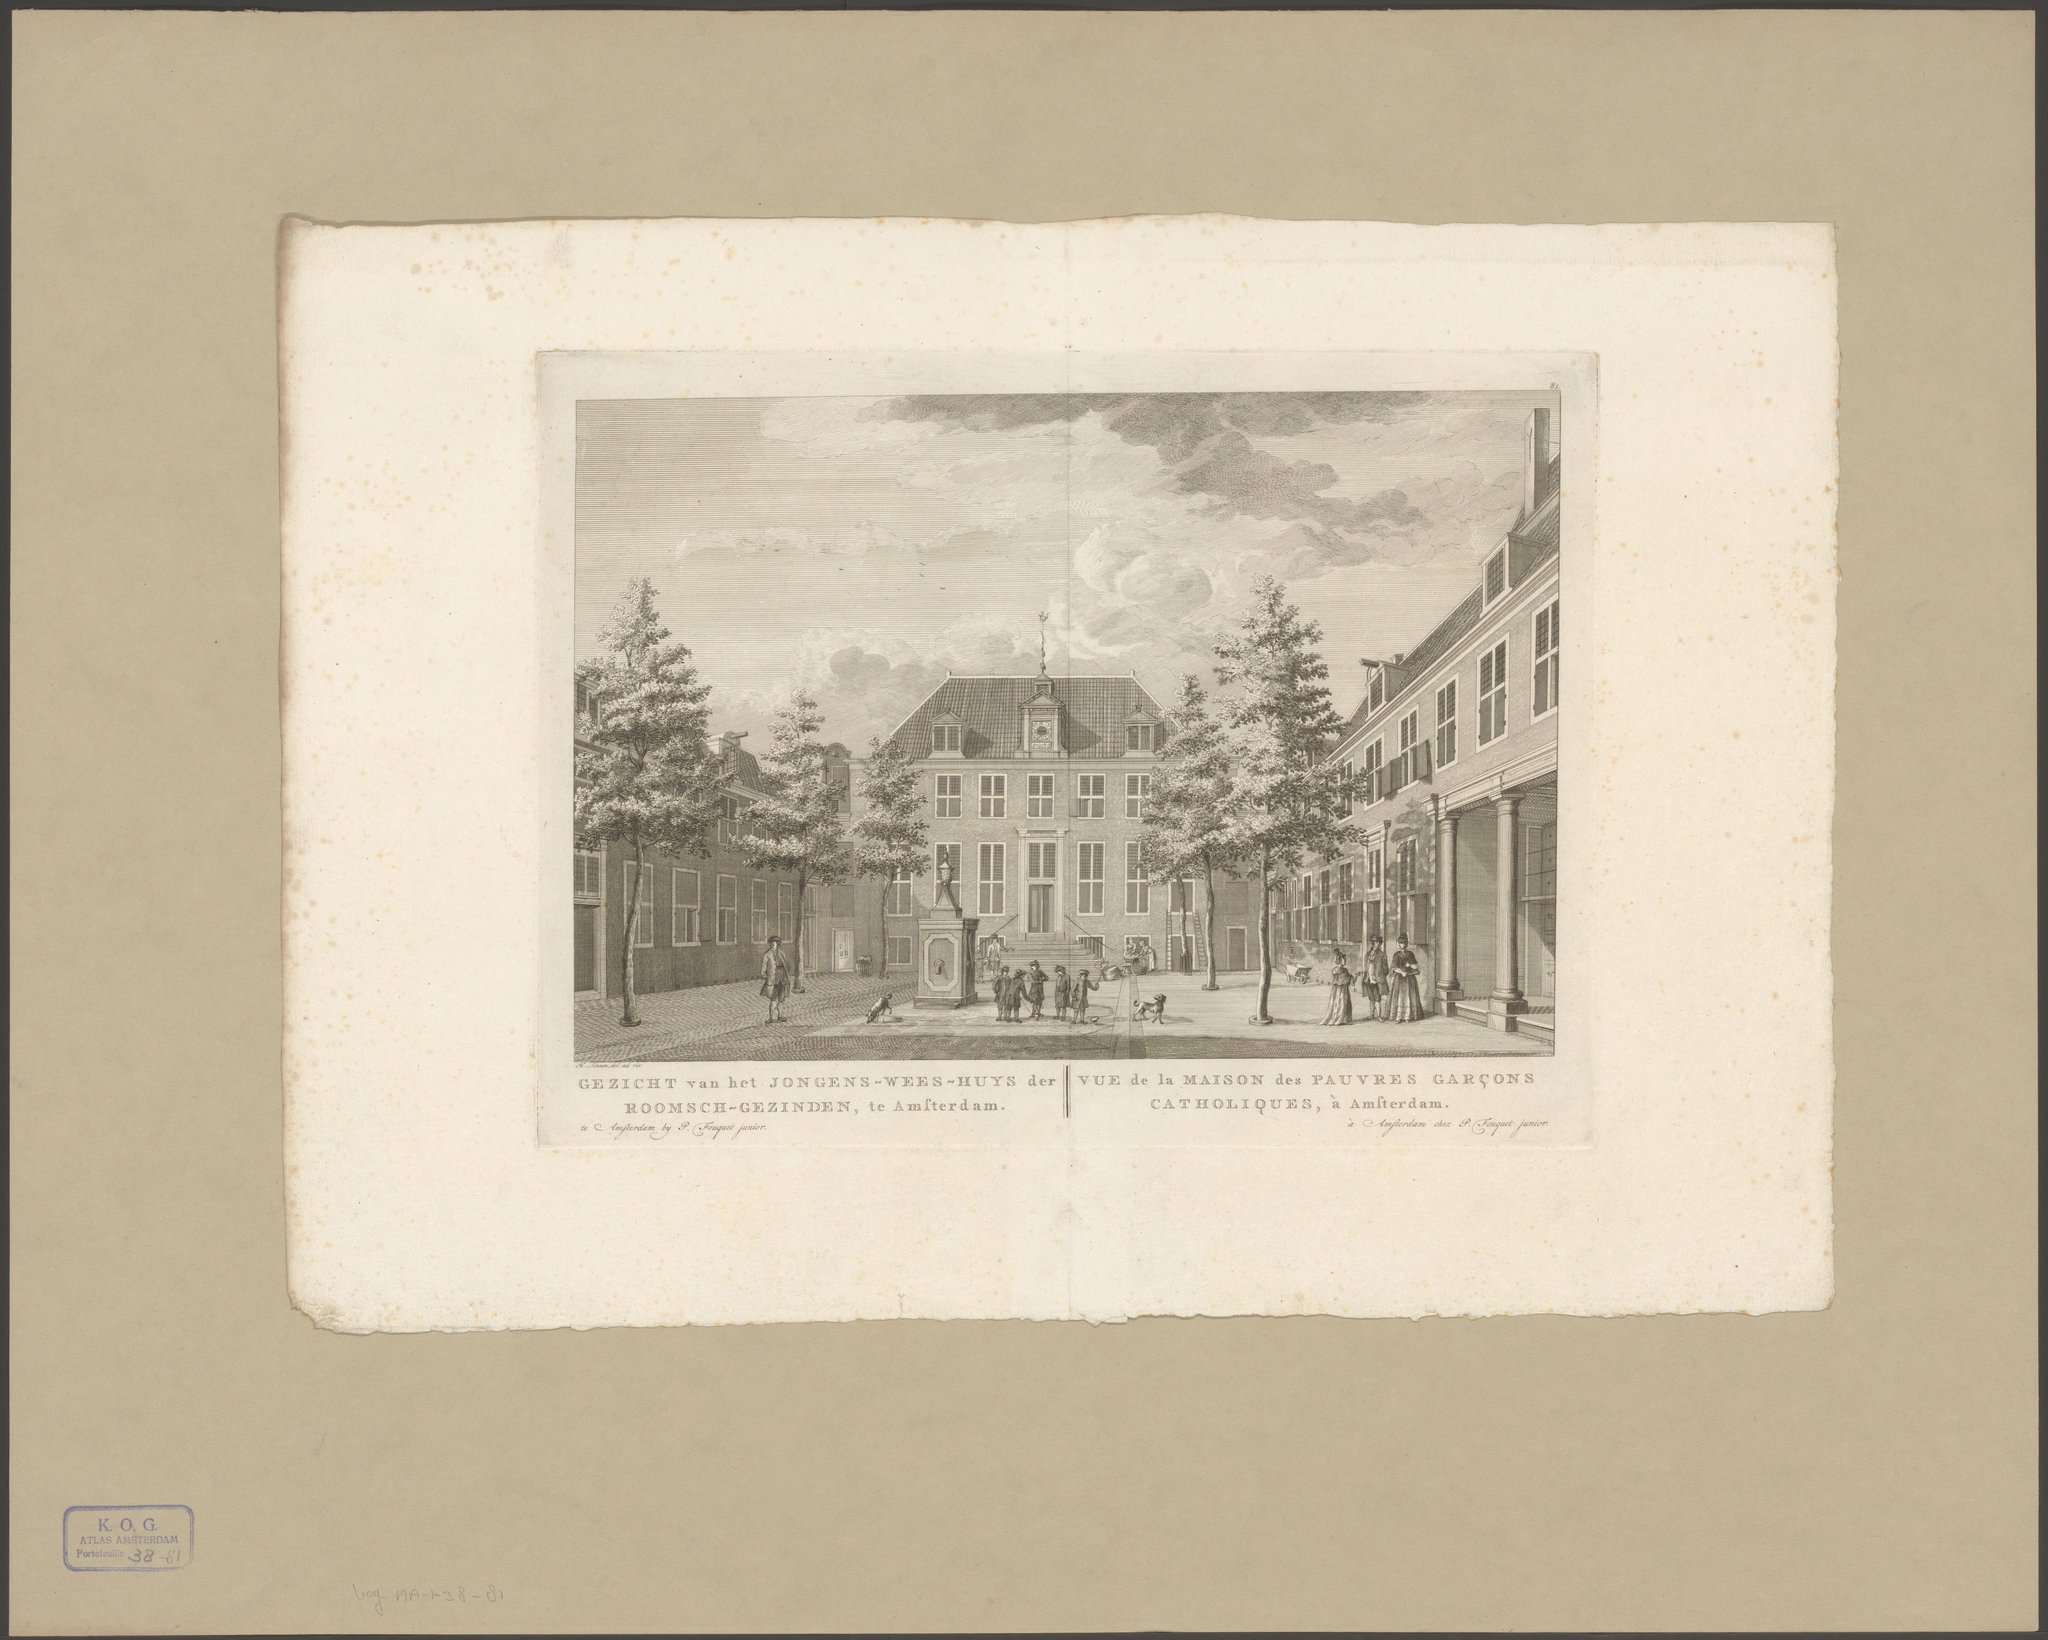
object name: print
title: Gezicht van het Jongens-Wees-Huys der Roomsch-Gezinden, te Amsterdam / Vue de la Maison des Pauvres Garçons Catholiques, à Amsterdam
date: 1770-1783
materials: paper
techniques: engraving, etching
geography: amsterdam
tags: courtyard, orphanage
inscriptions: collector's mark: Lugt 1641b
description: Vanaf 1760 gaf Pierre Fouquet stadsgezichten van Amsterdam naar tekeningen van verschillende kunstenaars uit. Deze prenten werden aanvankelijk los verkocht. Later werden ze samengebonden verkocht in verschillende volgordes en aantallen in: (1). Afbeeldingen van de wyd-vermaarde koopstad Amsterdam benevens des zelvs voornaamste gebouwen en gezigten alle naar het leeven getekend / Receuil des edifices les plus considerables et des plus belles vues, de la fameuse ville d'Amsterdam, dessinées d'après nature. Amsterdam: Pierre Fouquet, 1778-1783. Deze 'uitgave' bestond waarschijnlijk alleen uit een titelblad en inhoudsopgave van de tot dusver 100 uitgegeven prenten, die de koper zelf aan zijn of haar reeds verzamelde prenten kon toevoegen. De hoeveelheid en volgorde van prenten verzameld onder deze titel verschilt dus sterk. (2). Nieuwe atlas, van de voornaamste gebouwen en gezigten der stad Amsterdam, met derzelver beknopte beschryvingen. 2 dln. Amsterdam: Daniël Jean Changuion en Petrus den Hengst [in opdracht van Pierre Fouquet], 1783. Ook werden er door verschillende uitgevers tussen 1788 (Amsterdam: Petrus Conradi) en 1805 (Amsterdam: Evert Maaskamp) heruitgaven gepubliceerd.